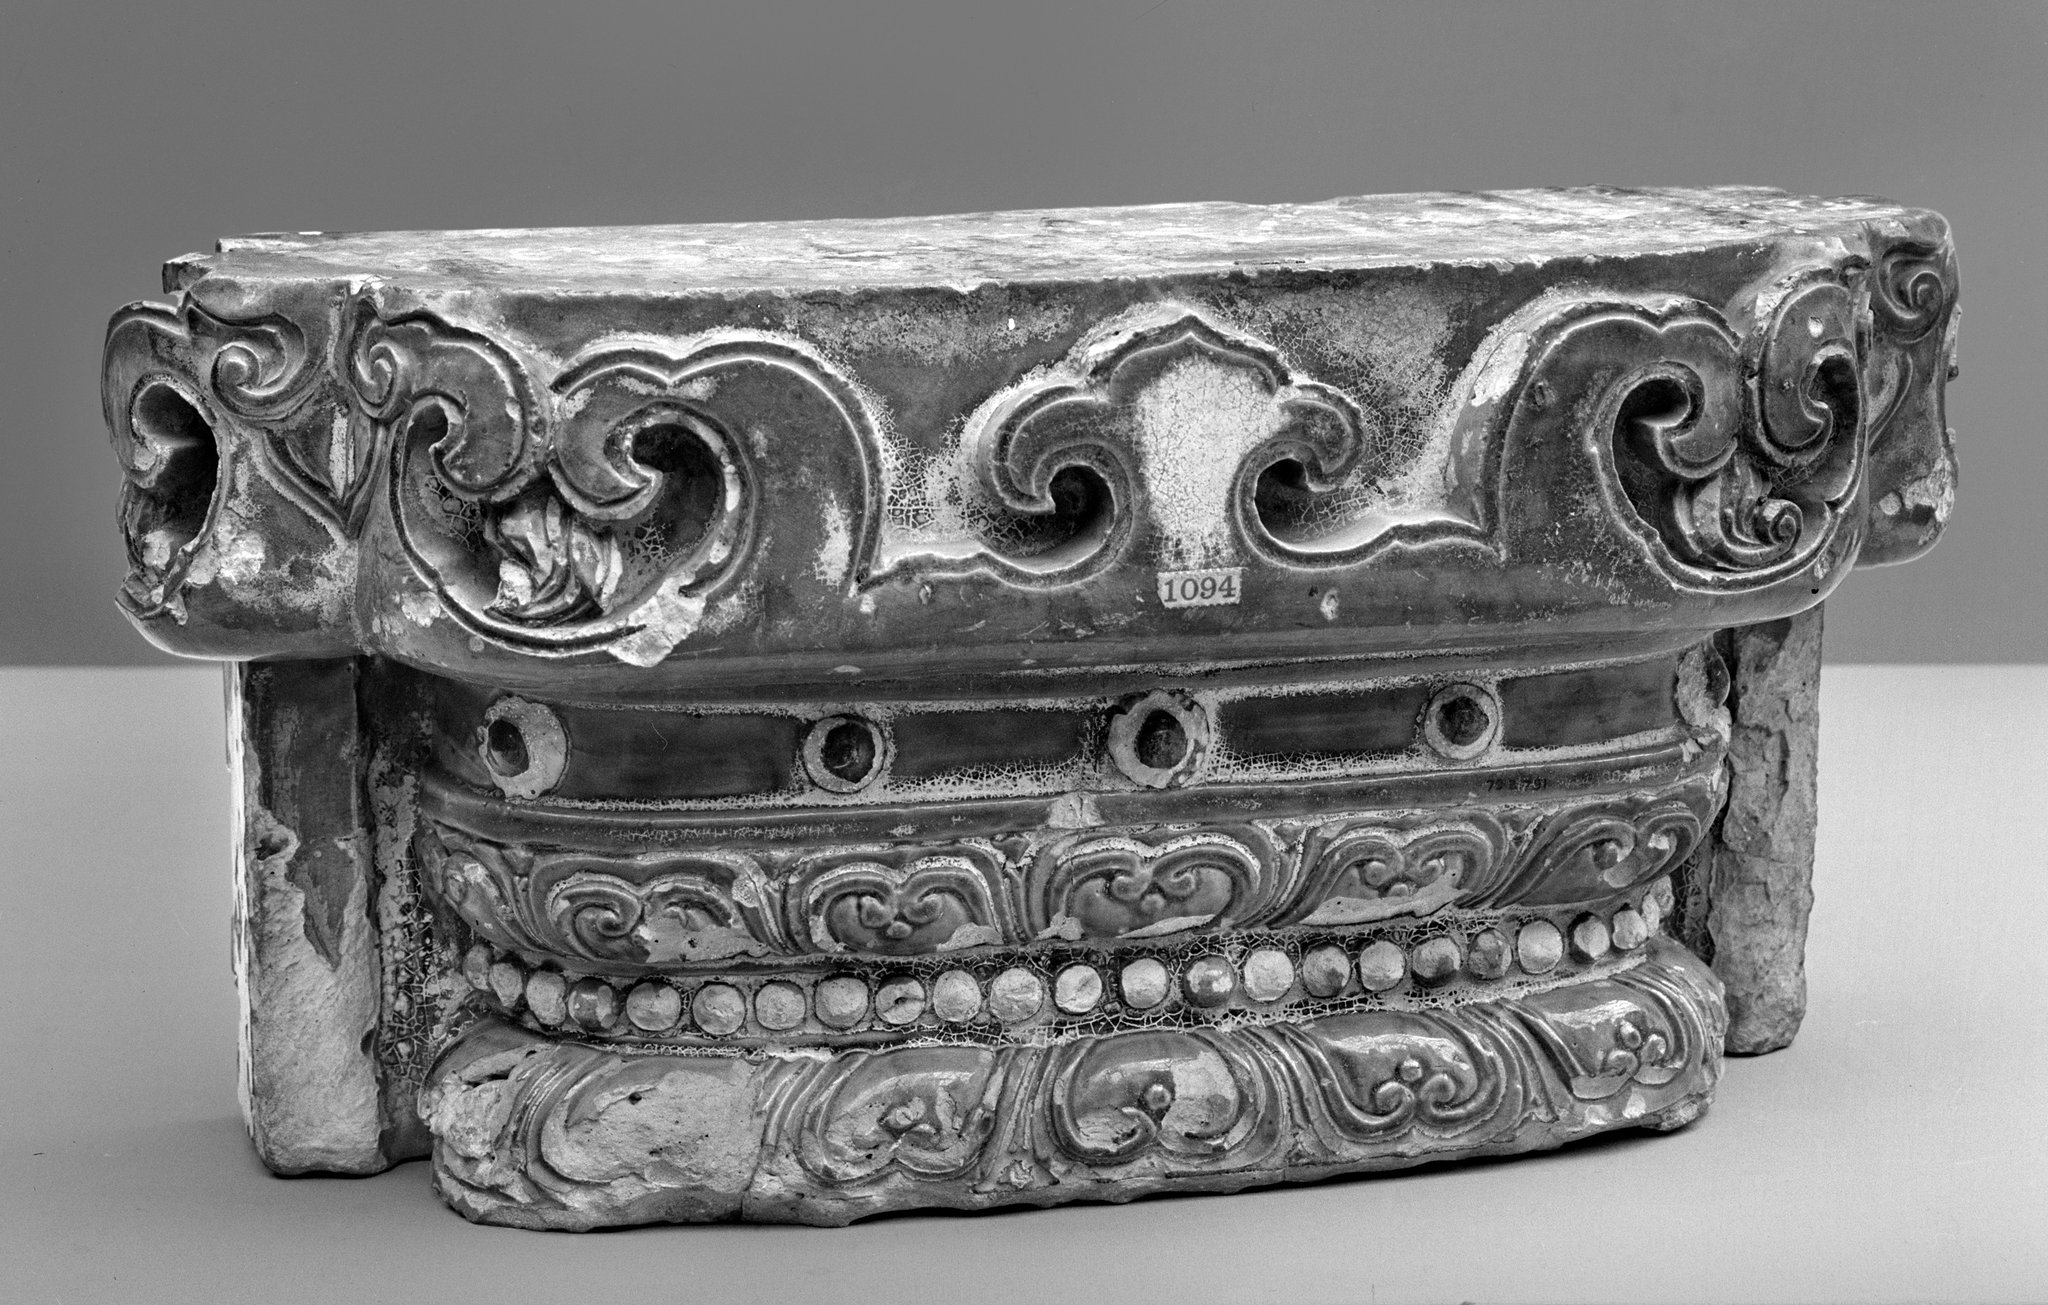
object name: architectural fragment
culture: chinese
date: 1401-1433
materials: glaze, stoneware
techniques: polychrome